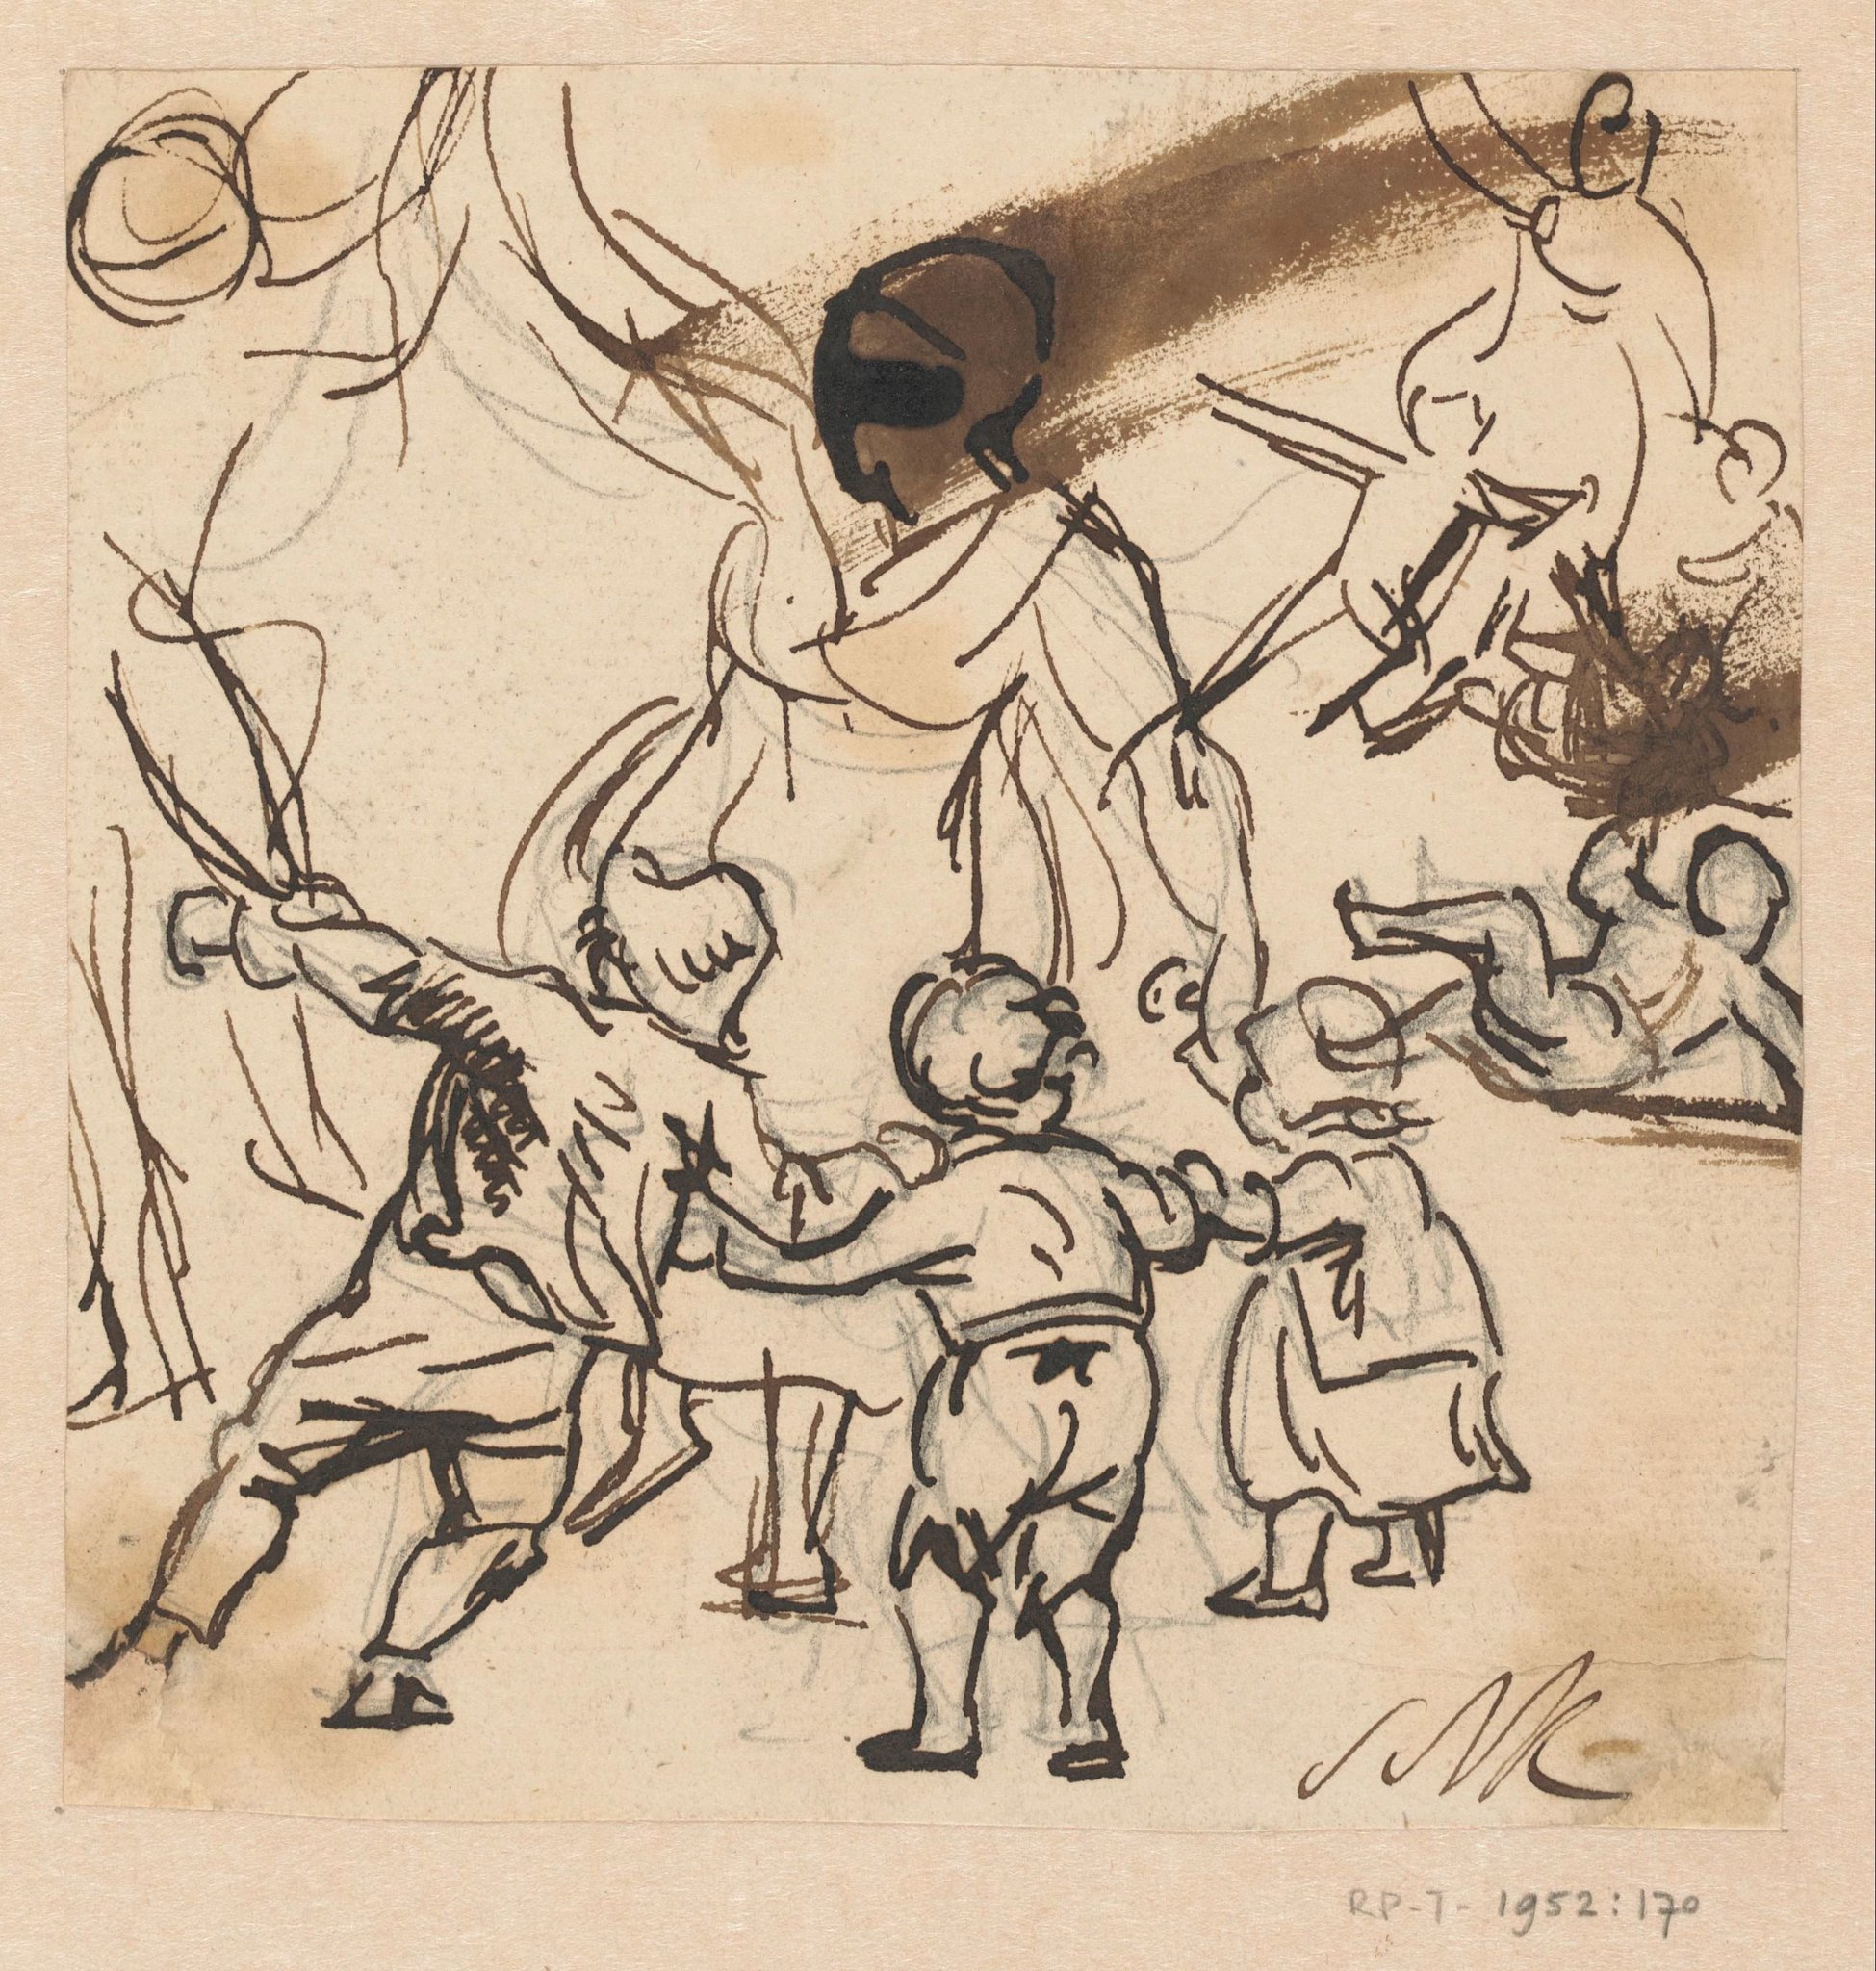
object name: drawing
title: Man en vrouw met drie kinderen, dansend in een kring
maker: simon andreas krausz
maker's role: draughtsman, print maker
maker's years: 1760-1825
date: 1770-1825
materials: ink, paper, pencil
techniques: pen